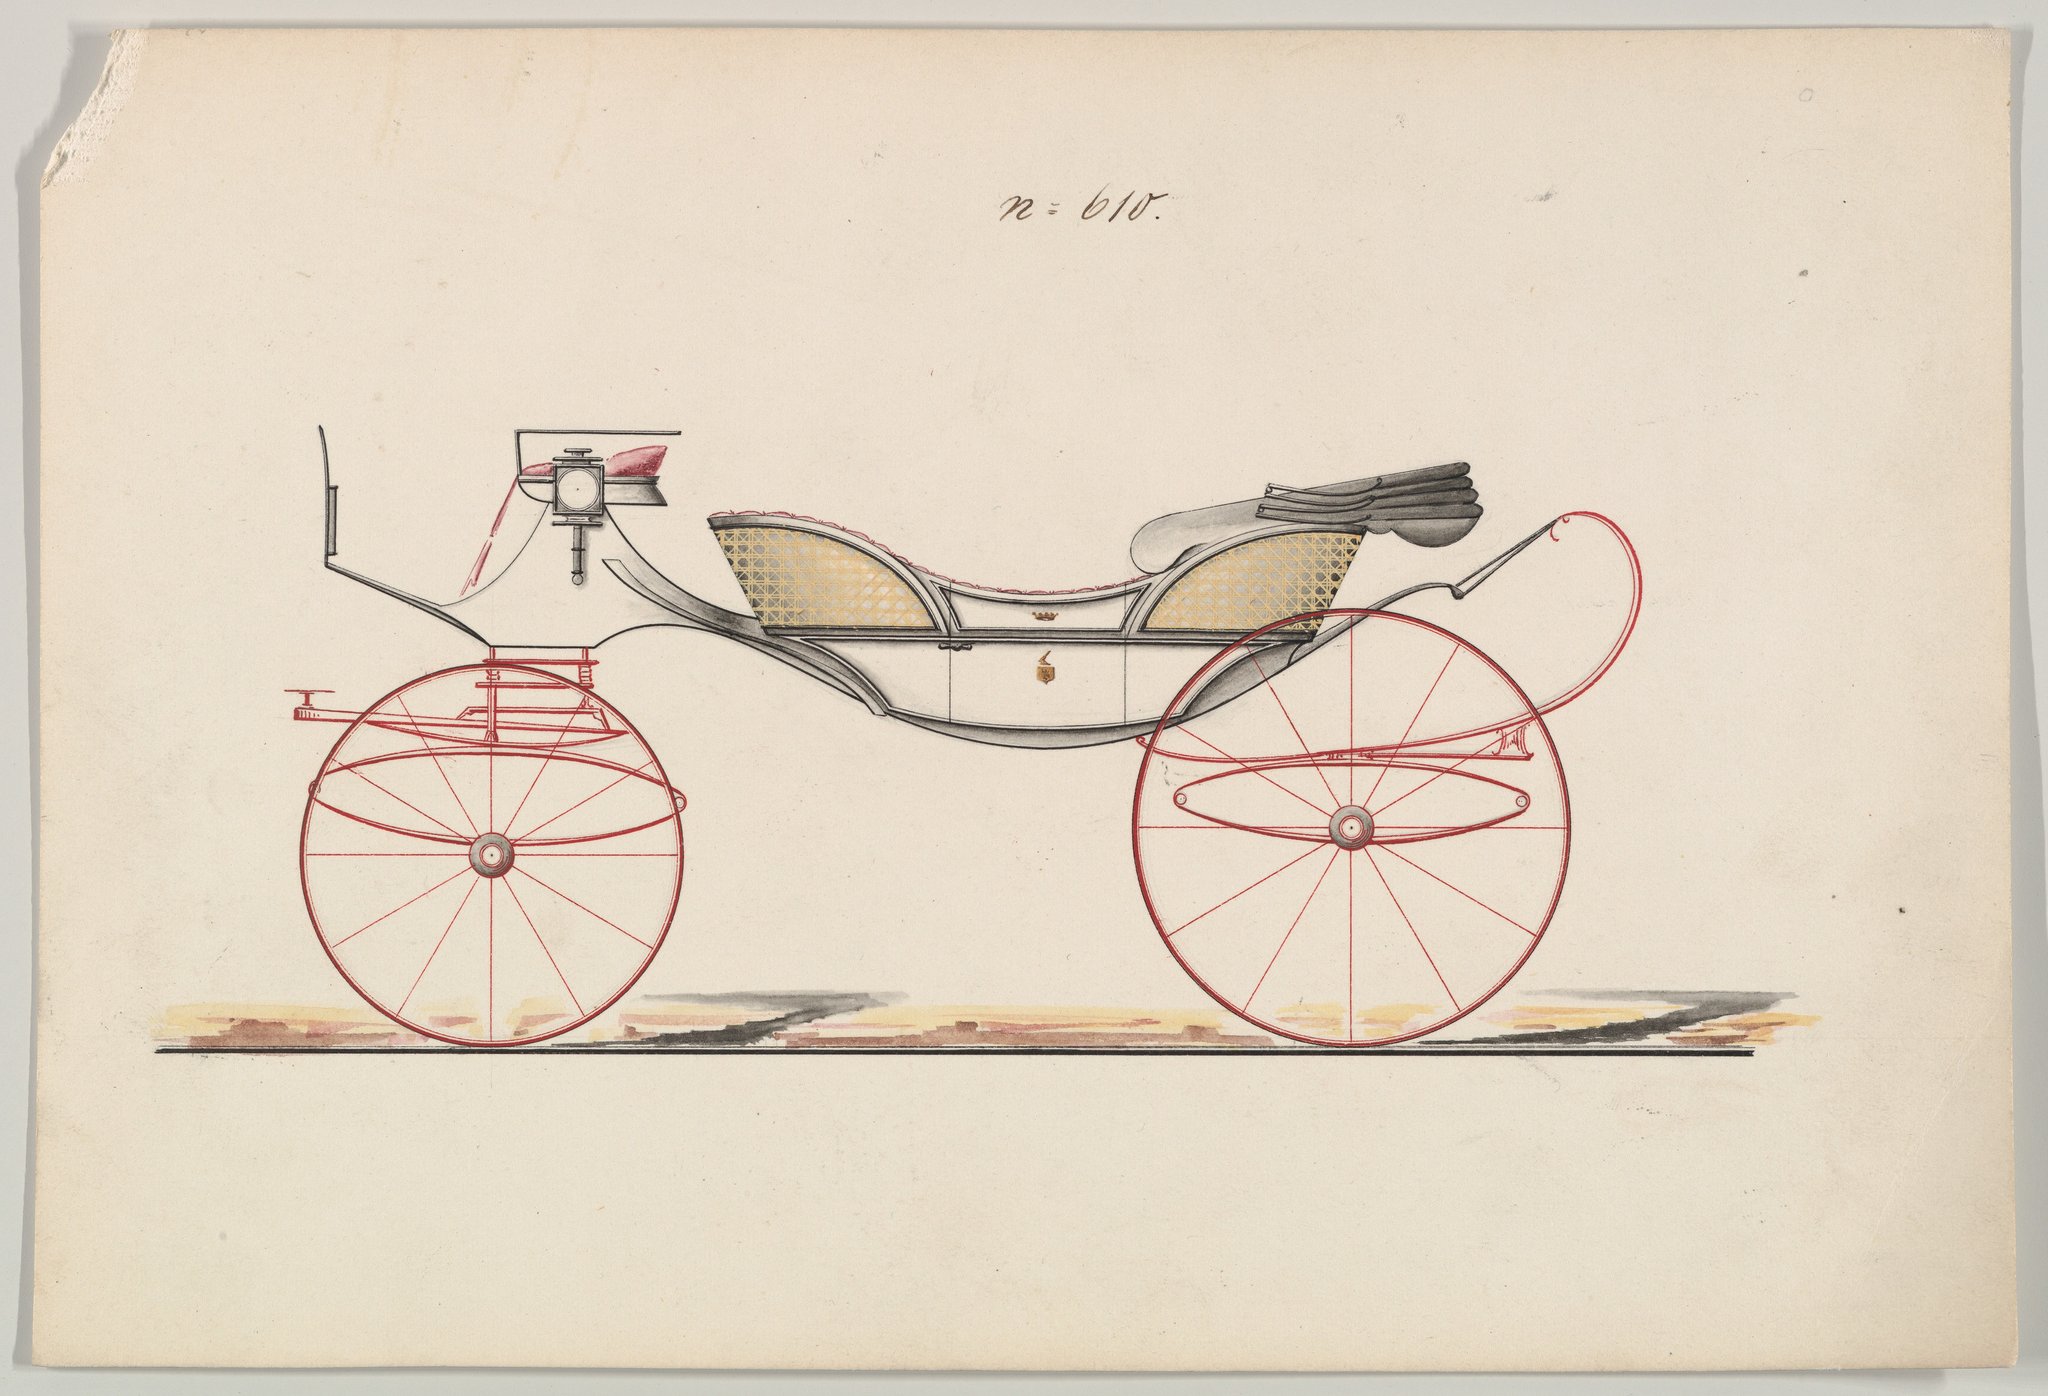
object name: drawing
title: Design for Vis-à-vis, no. 610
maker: brewster & co.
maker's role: manufacturer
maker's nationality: american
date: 1850-1870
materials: gouache, ink, watercolor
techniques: pen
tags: carriages